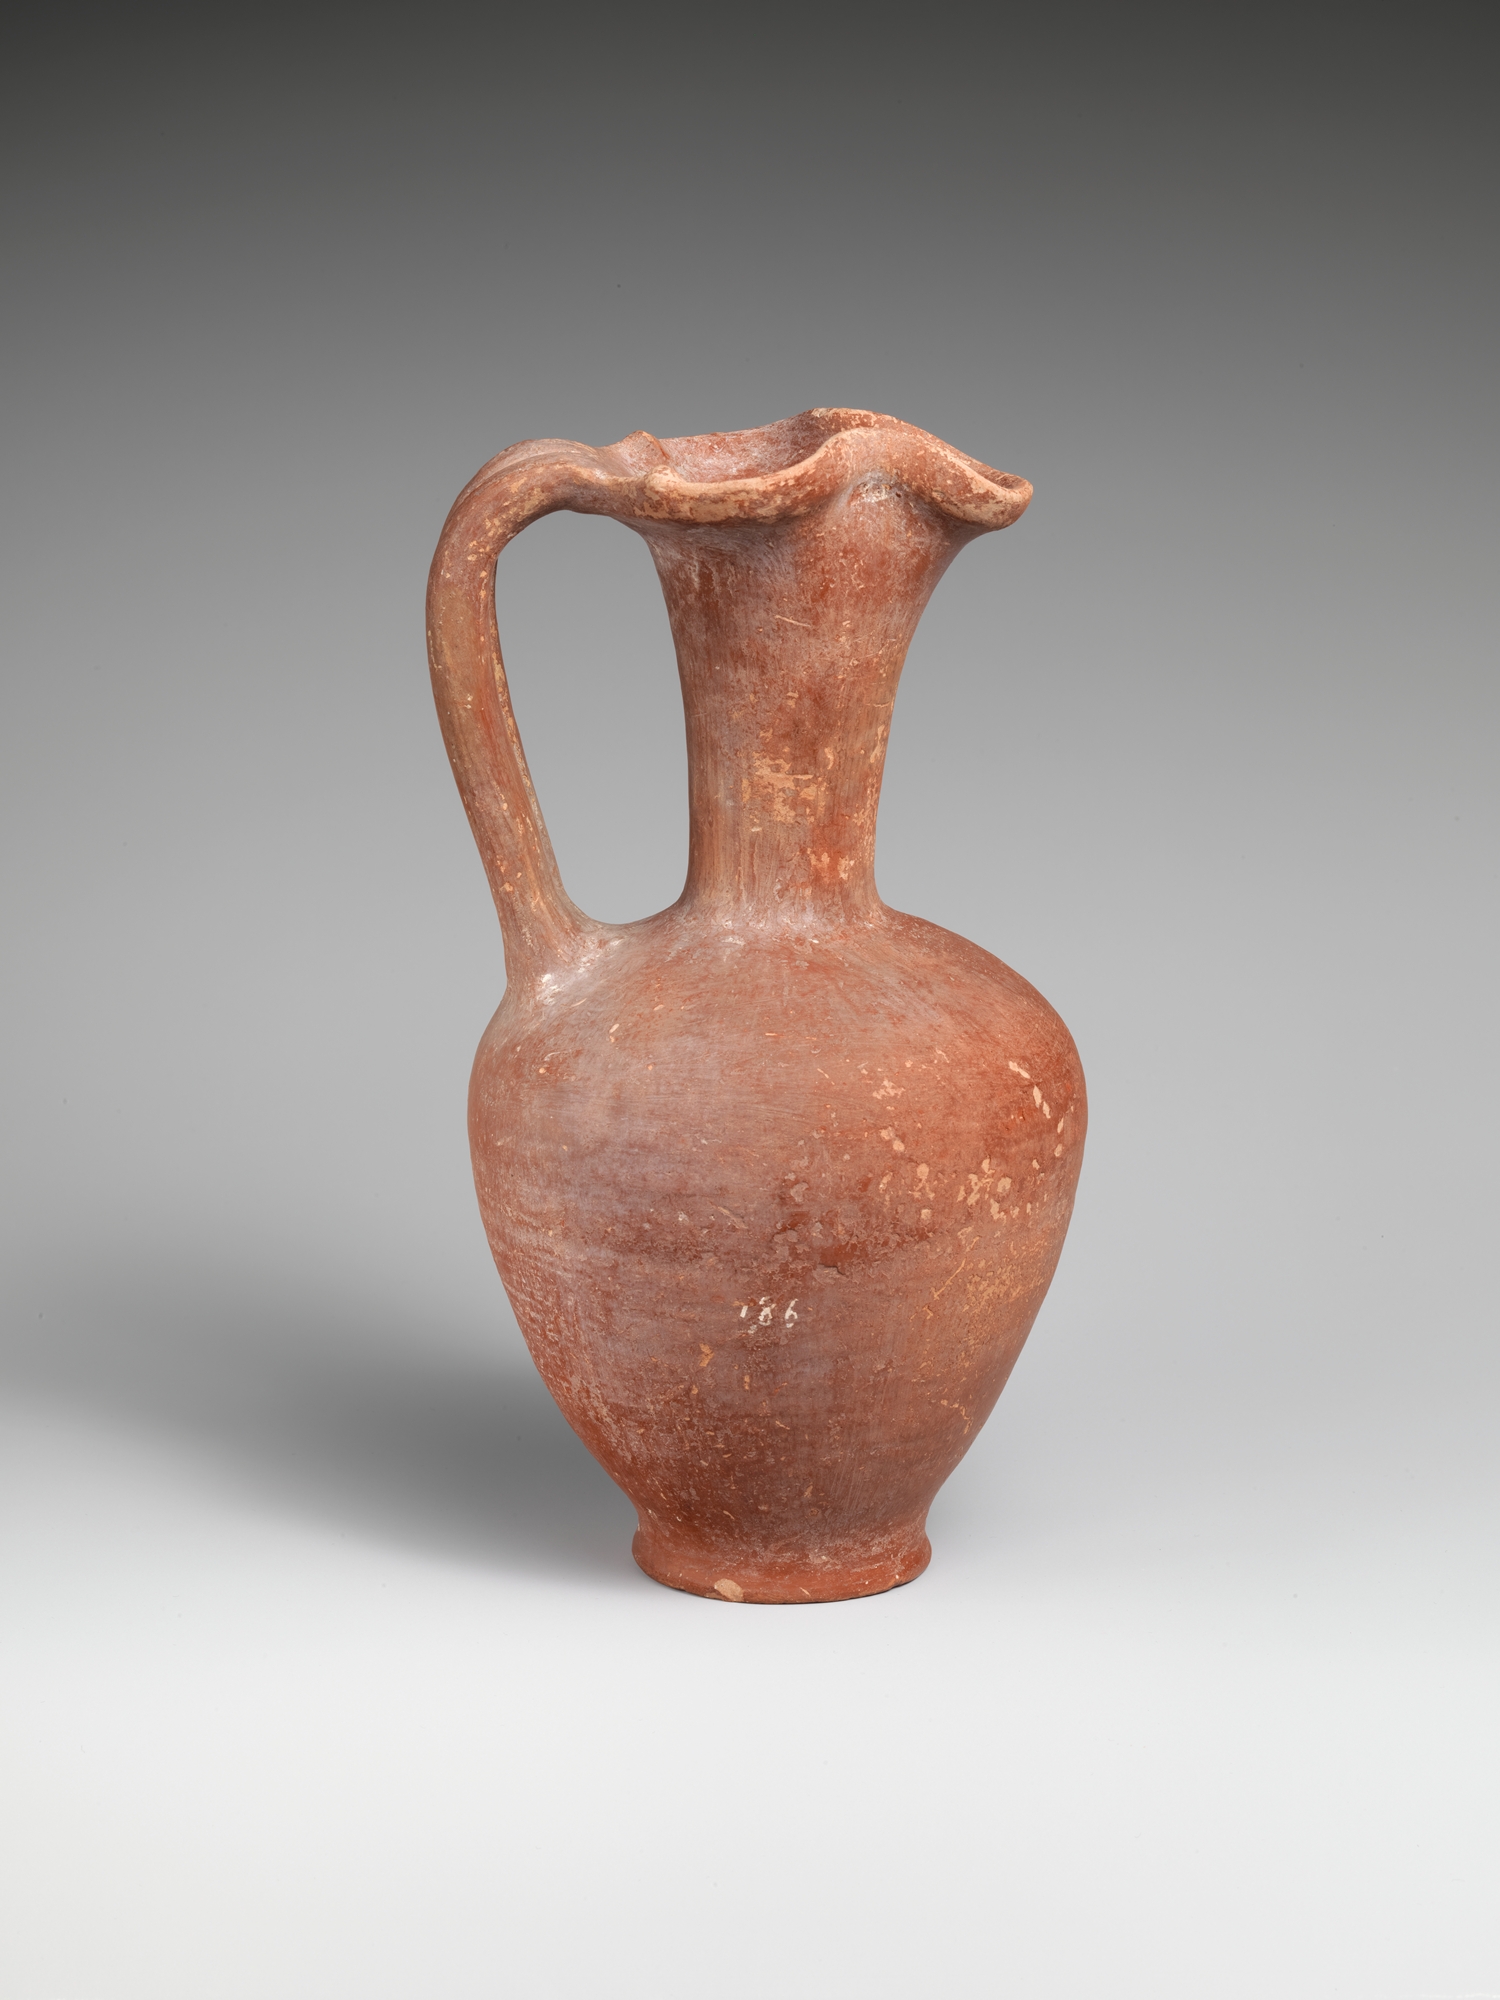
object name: oinochoe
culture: cypriot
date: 800-700 BCE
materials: terracotta